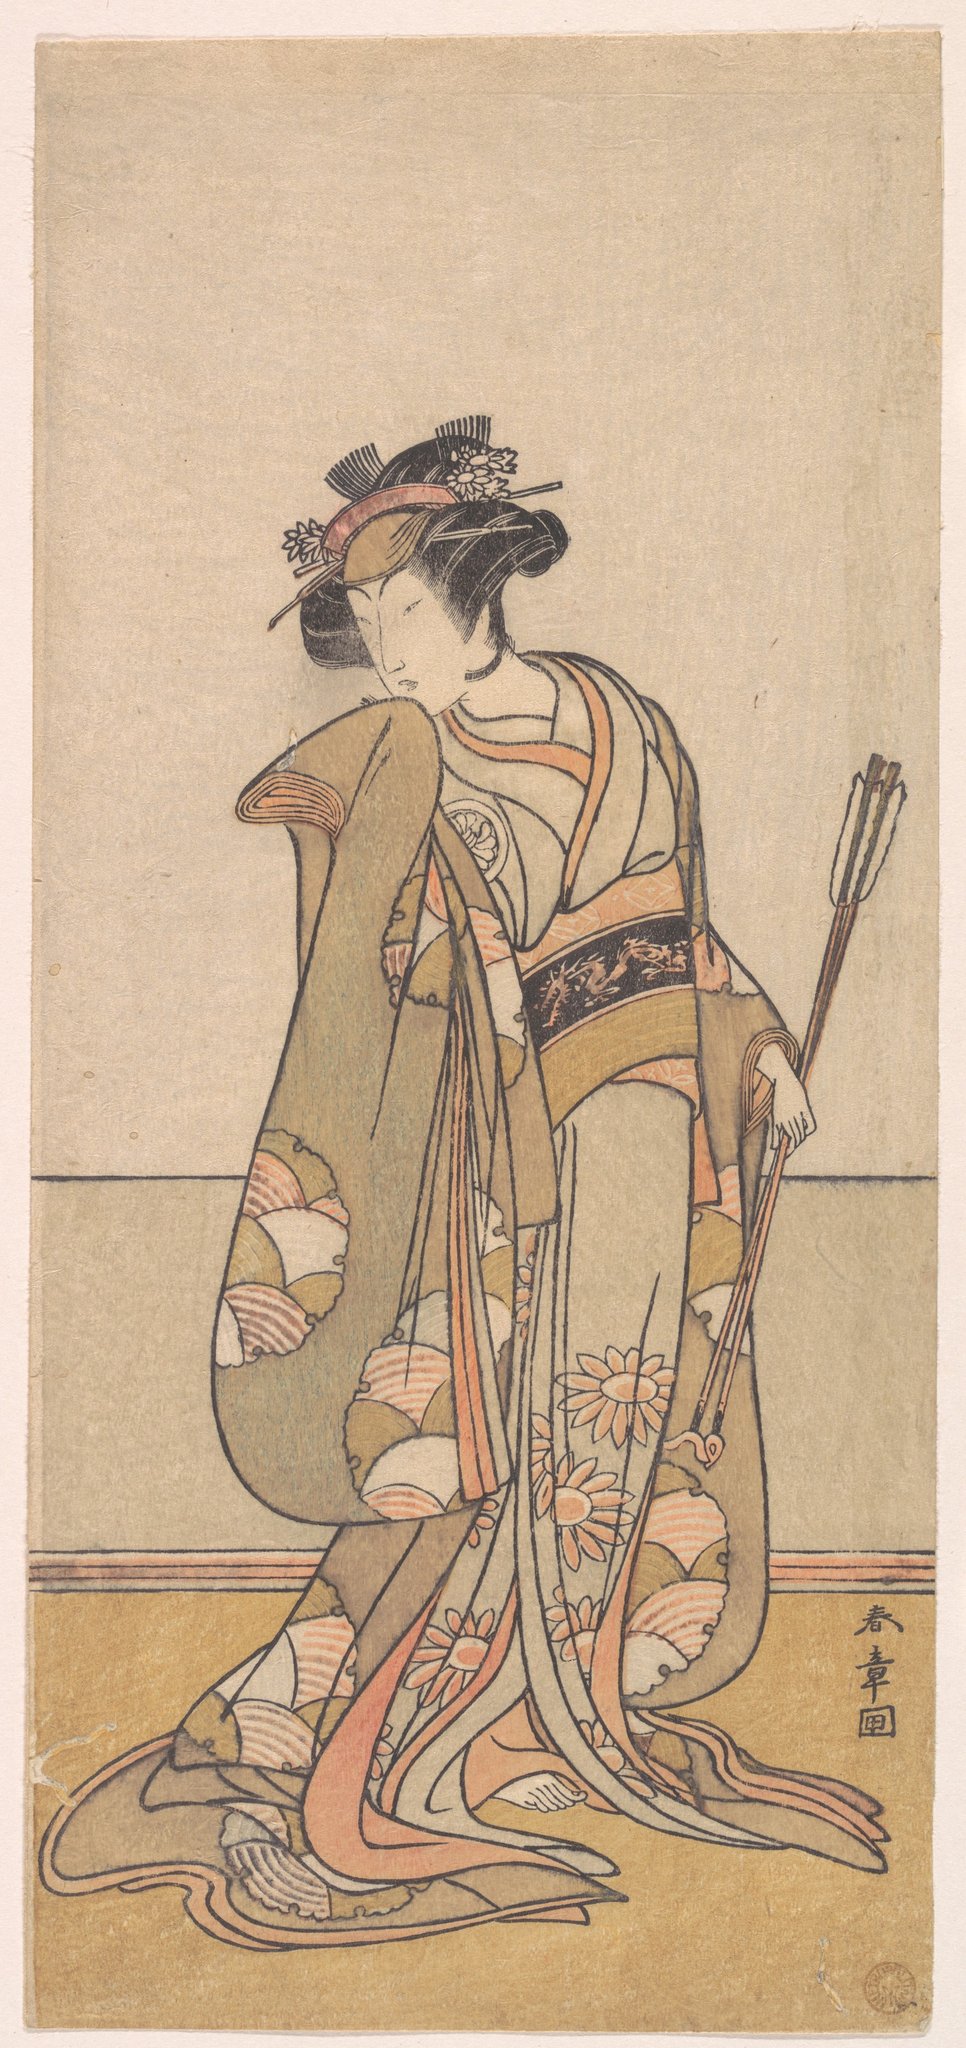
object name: woodblock print nishiki e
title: The Third Segawa Kikunojo as a Woman Walking Toward the Right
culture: japanese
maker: katsukawa shunshō 勝川春章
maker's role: artist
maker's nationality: japanese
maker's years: 1726-1792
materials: ink, paper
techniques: nishiki e, woodblock print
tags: arrows,actors